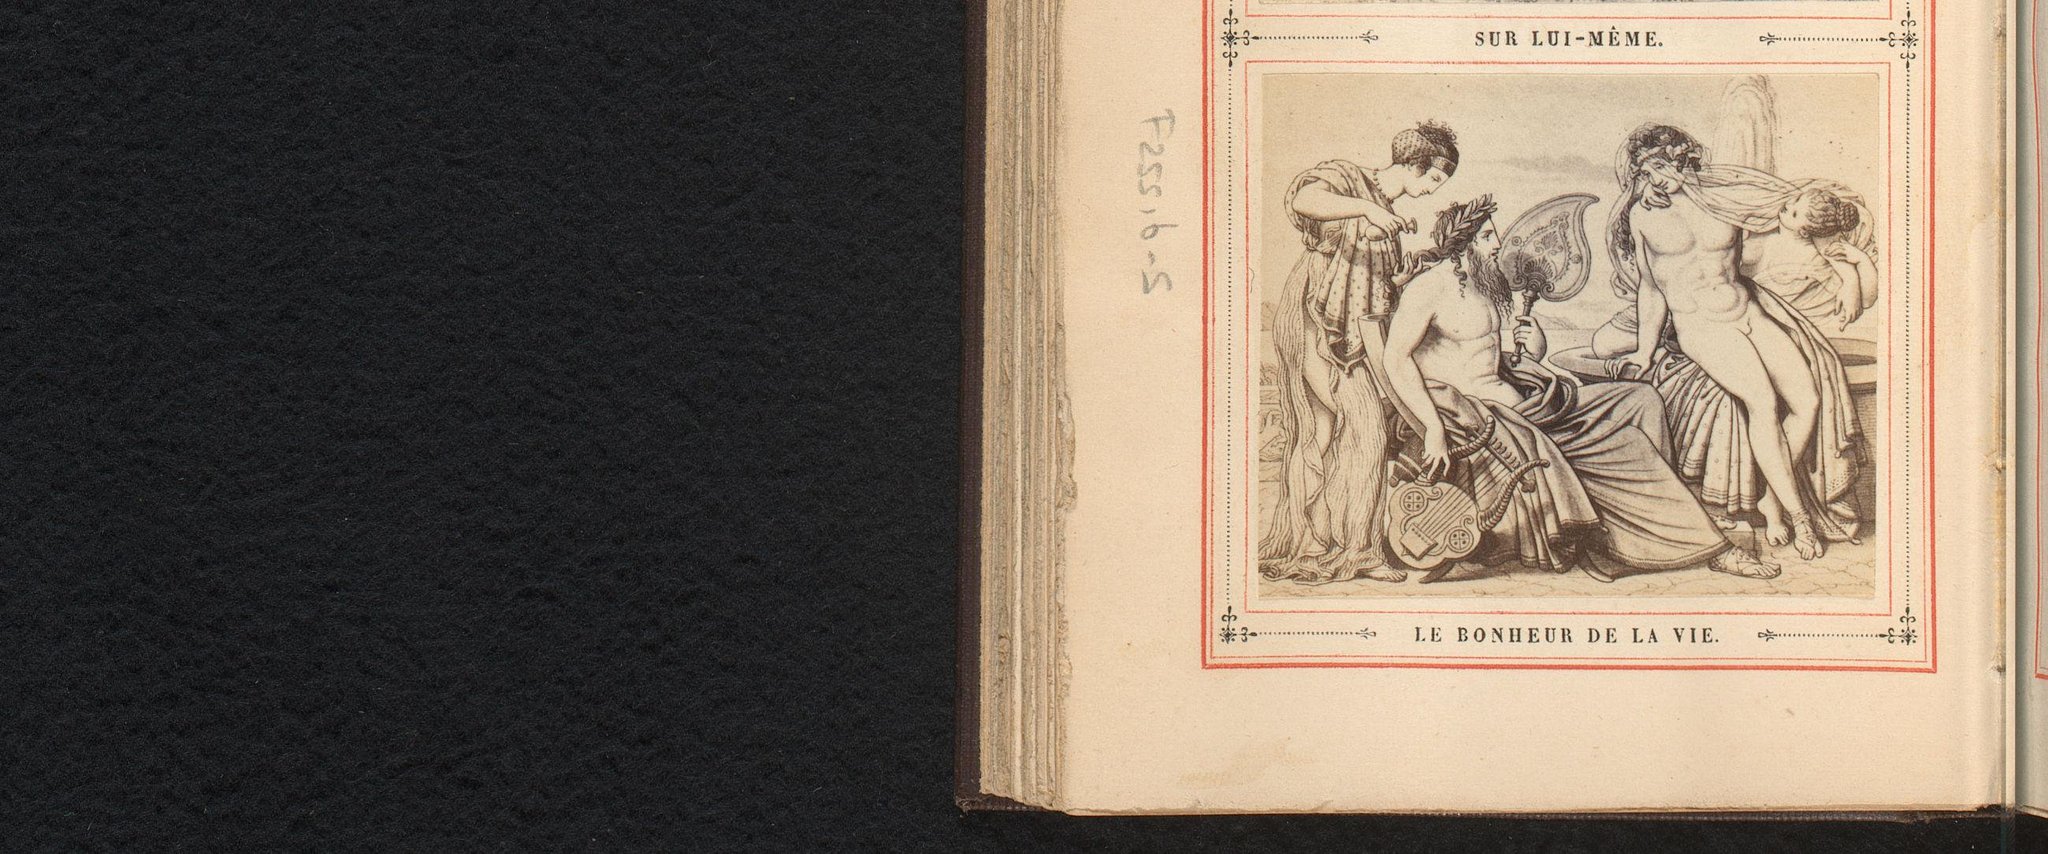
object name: photograph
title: Fotoreproductie van een tekening van Girodet, luierende goden, illustratie bij Apothéose d'Anacréon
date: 1859-1864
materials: paper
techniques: albumen print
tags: gods ~ classical mythology